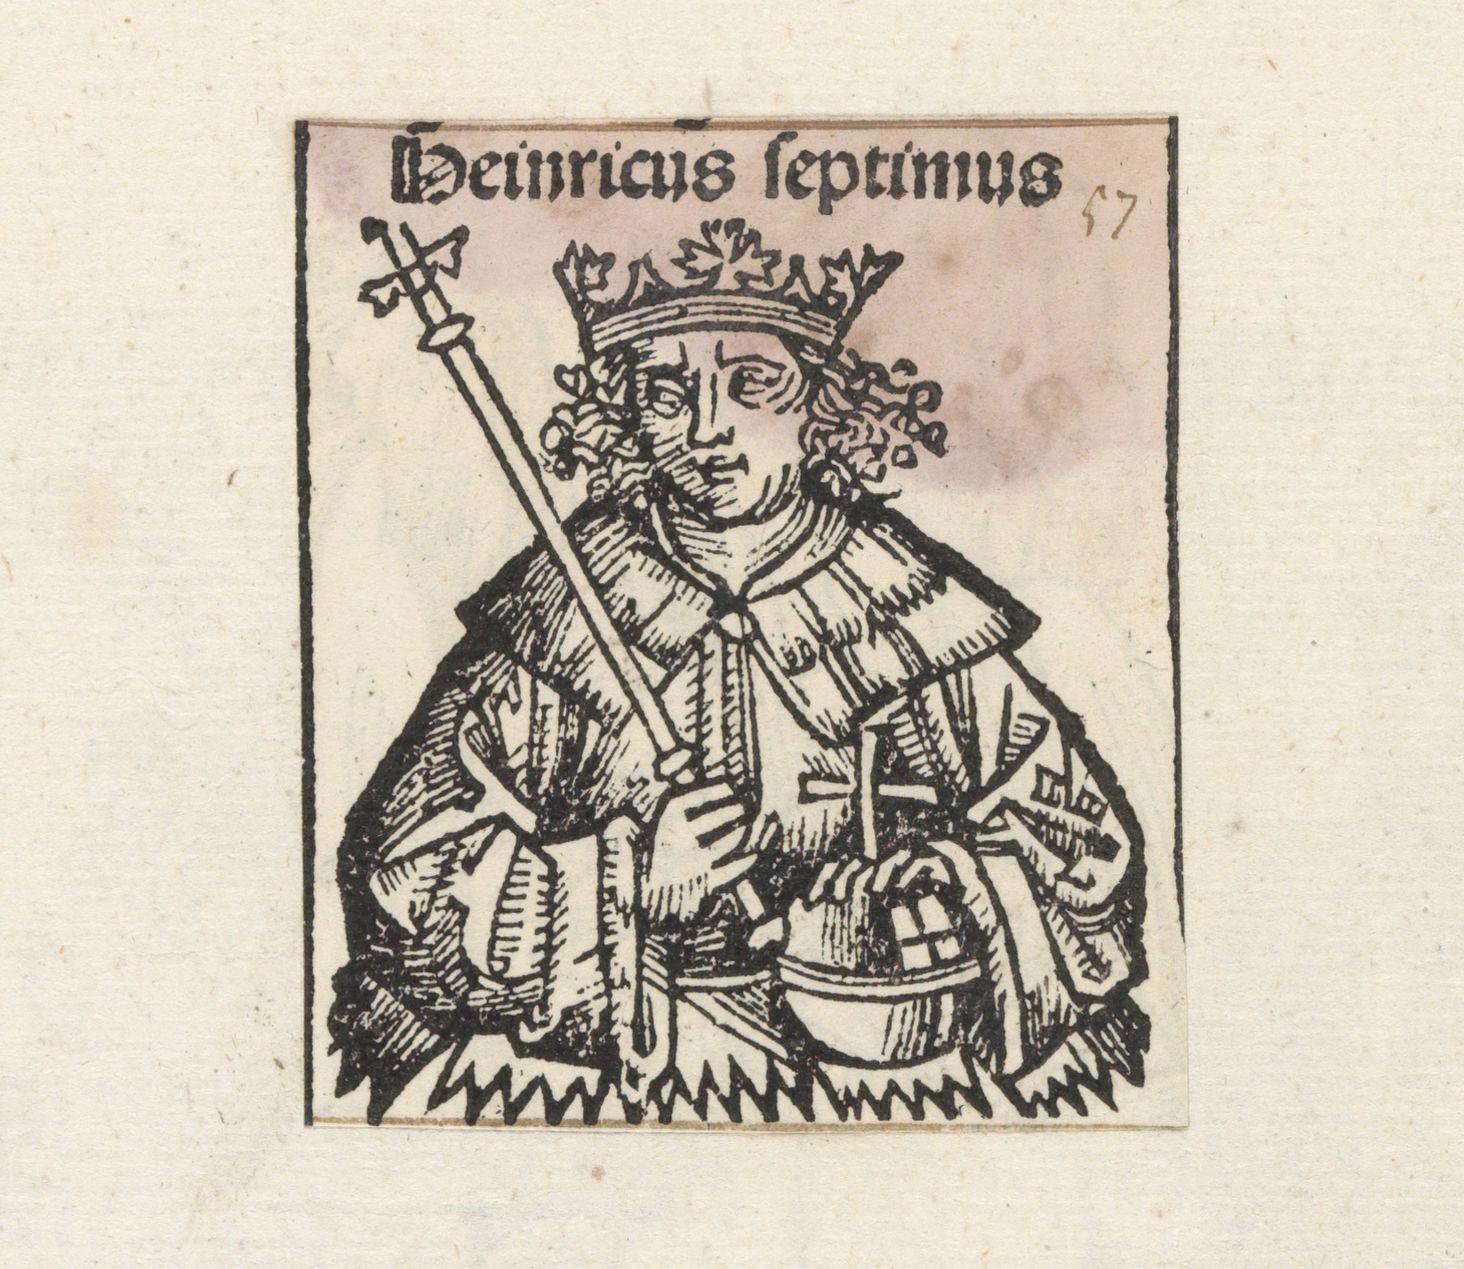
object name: album leaf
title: Liber Chronicarum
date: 1493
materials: paper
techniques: letterpress printing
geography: nuremberg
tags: emperor, king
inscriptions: inscription: ‘57’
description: Een bloemkelk met een koning, naar voren gericht. In zijn handen heeft hij een rijksappel en een scepter. De voorstelling is onderdeel van de opeenvolging keizers in de Liber Chronicarum. De tekst identificeert de man als Hendrik Raspe. De prent maakt deel uit van een album.